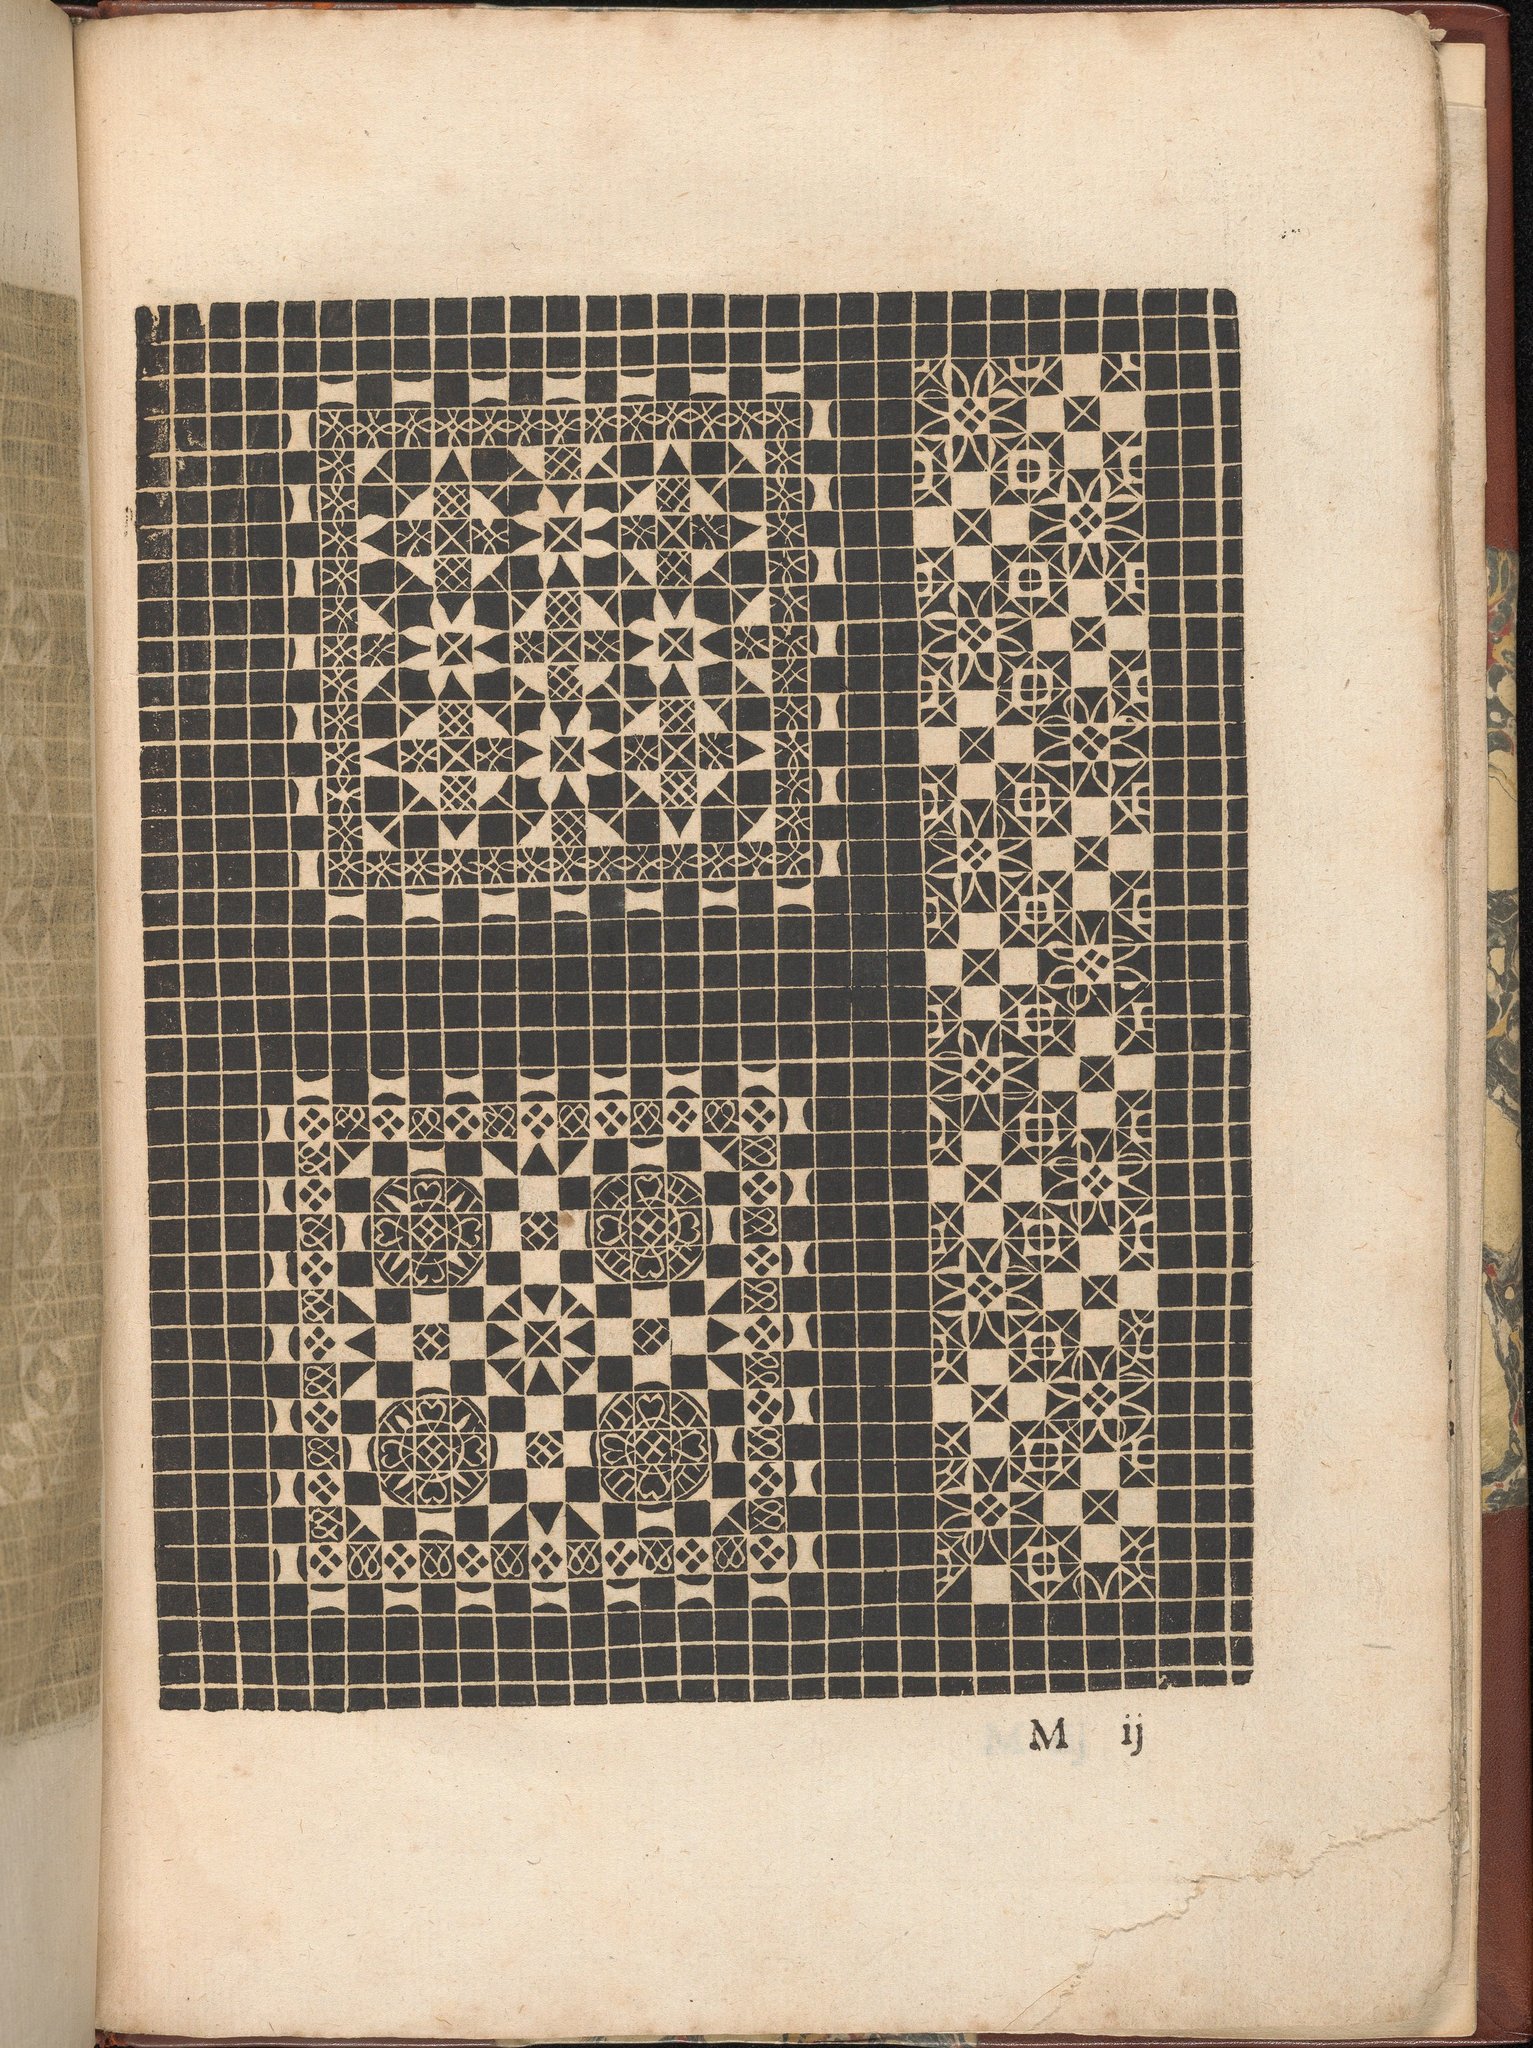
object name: book print ornament architecture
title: Les Secondes Oeuvres, et Subtiles Inventions De Lingerie du Seigneur Federic de Vinciolo Venitien, page 46 (recto)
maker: federico de vinciolo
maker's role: designer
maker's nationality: italian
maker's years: 1582-1599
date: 1603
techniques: woodcut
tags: ornament